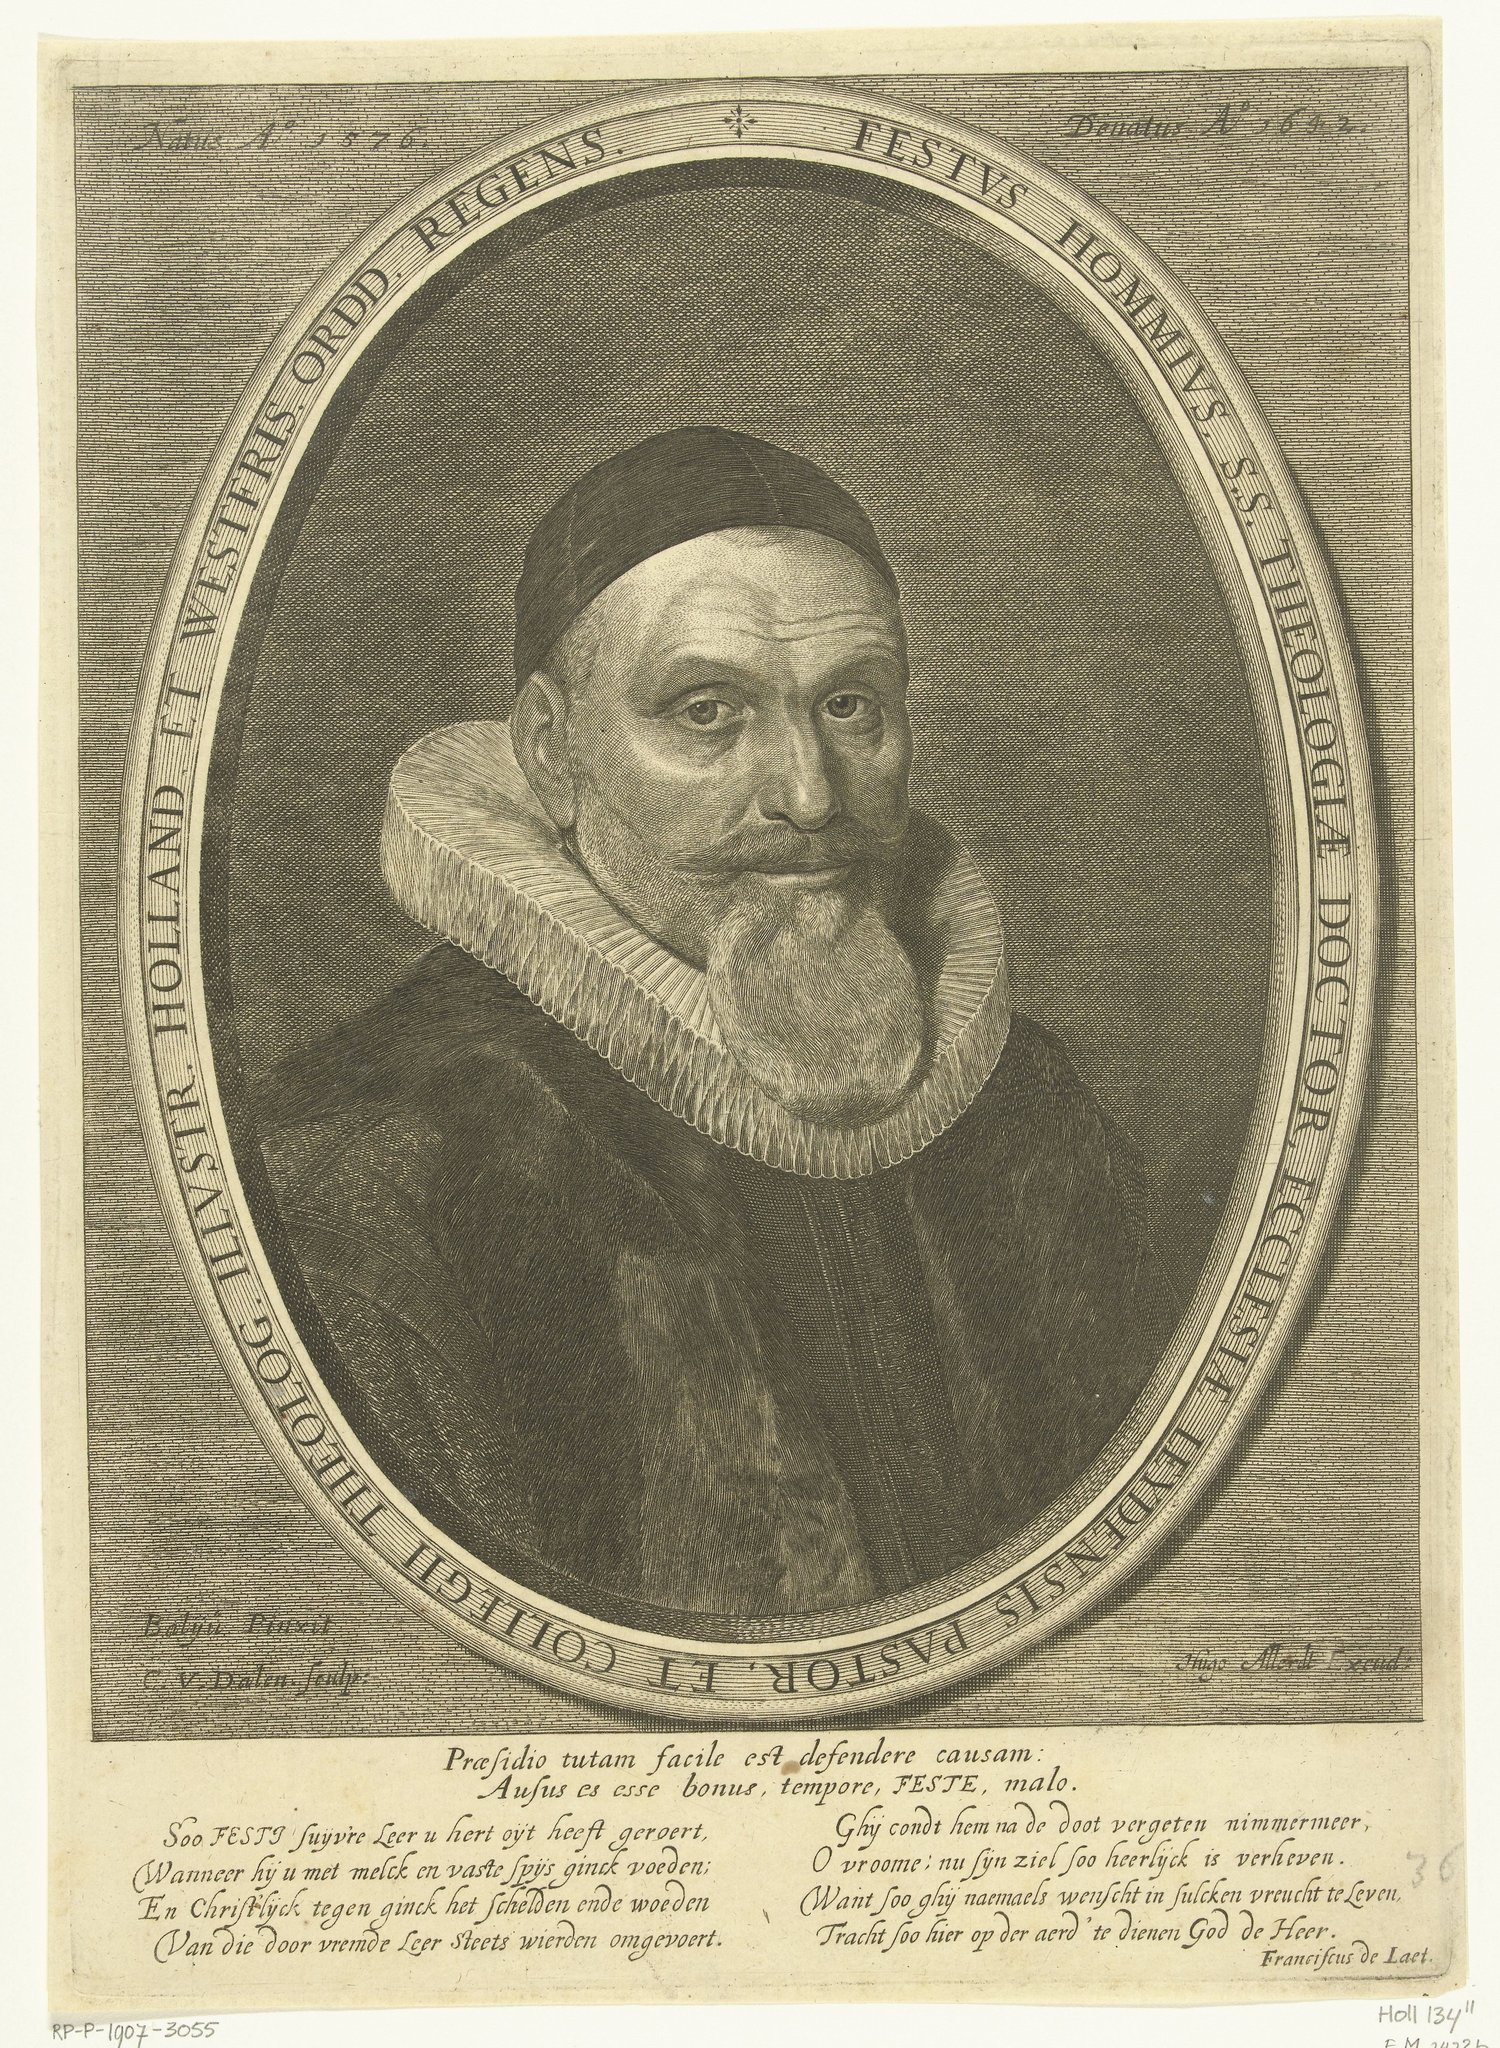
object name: print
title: Festvs Hommivs S.S. Theologiae (...) Westfris. ordd. regens.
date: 1642-1665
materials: paper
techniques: engraving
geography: amsterdam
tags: leiden, functionaries and dignitaries (with name) ~ episcopal protestant churches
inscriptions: collector's mark: Lugt 2228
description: Portret van Festus Hommius, predikant te Leiden. Borststuk in ovale omlijsting. In de marge een Nederlands vers van Franciscus de Laet.